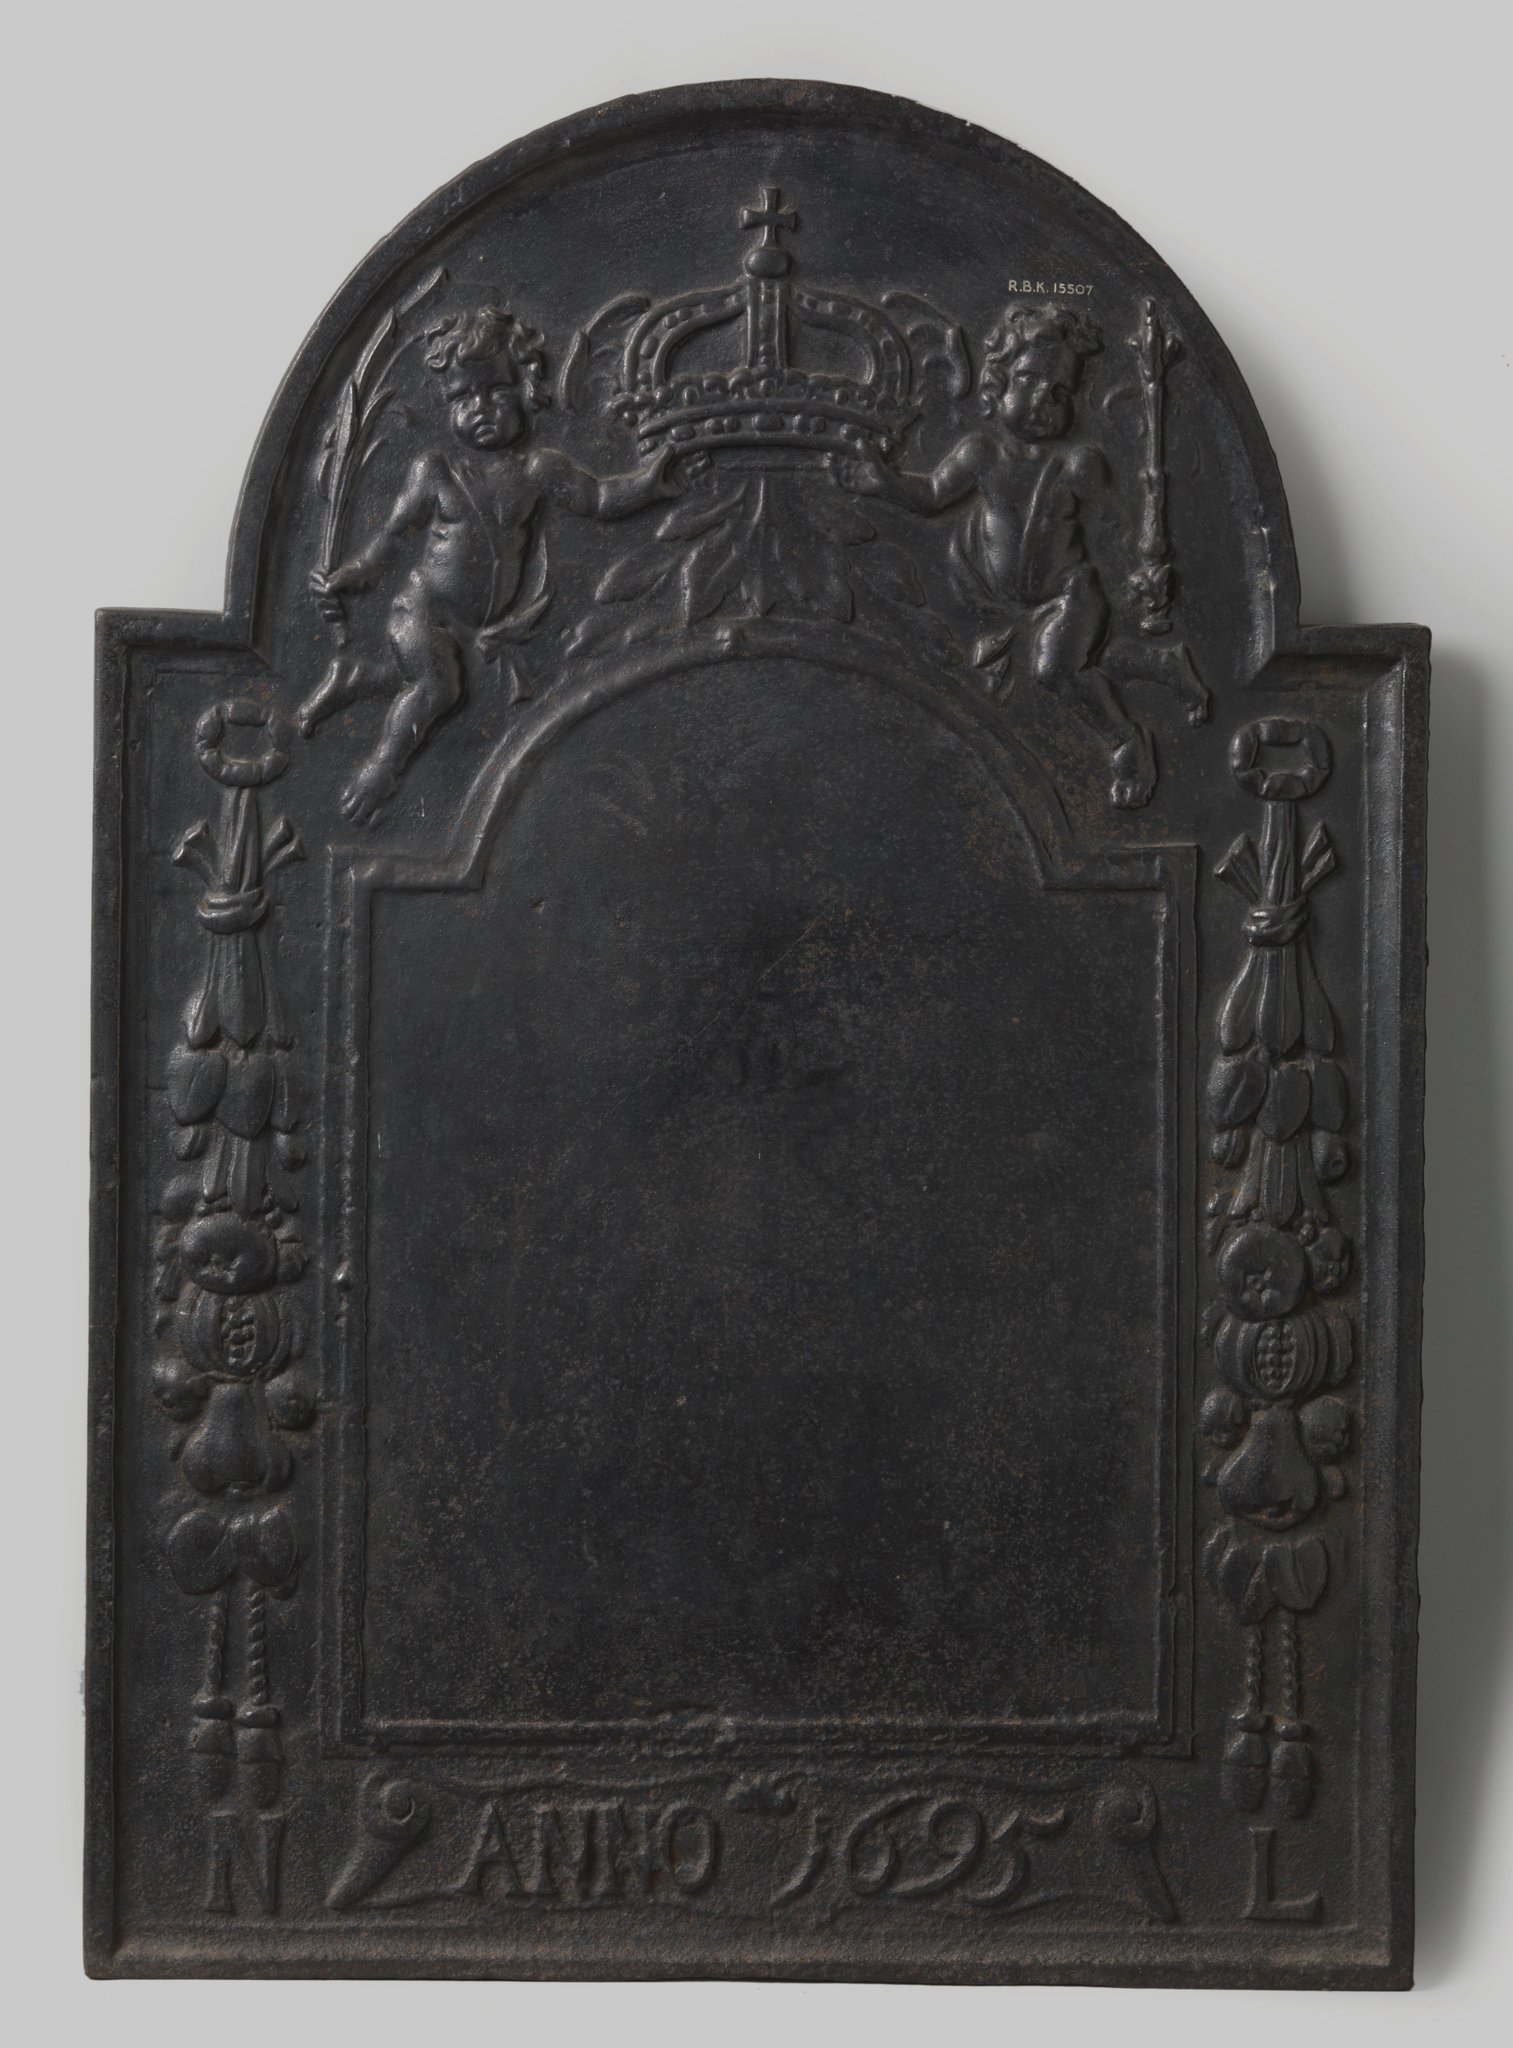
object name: fireback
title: Haardplaat met kroon tussen putti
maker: Anonymous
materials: iron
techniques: casting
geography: germany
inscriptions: inscription: ‘NL’, inscription: ‘ANNO 1695’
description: Een haardplaat van gietijzer in staand rechthoekige vorm, en van boven overgaande in een smallere halve cirkelboog met geprofileerde lijst, De omtrek wordt in het midden vlak gerepeteerd door een dubbele lijst, welke een vlak en onversierd, enigszins verhoogd liggend veld omvat. Tussen deze beide lijsten is het ornament aangebracht, bestaande, uit een kroon, waaraan laurieren hangen, gedragen door zwevende engelen. Aan beide zijden uit vruchten festoenen hangende aan koorden; ANNO 1696, geflankeerd door de letters N en L.